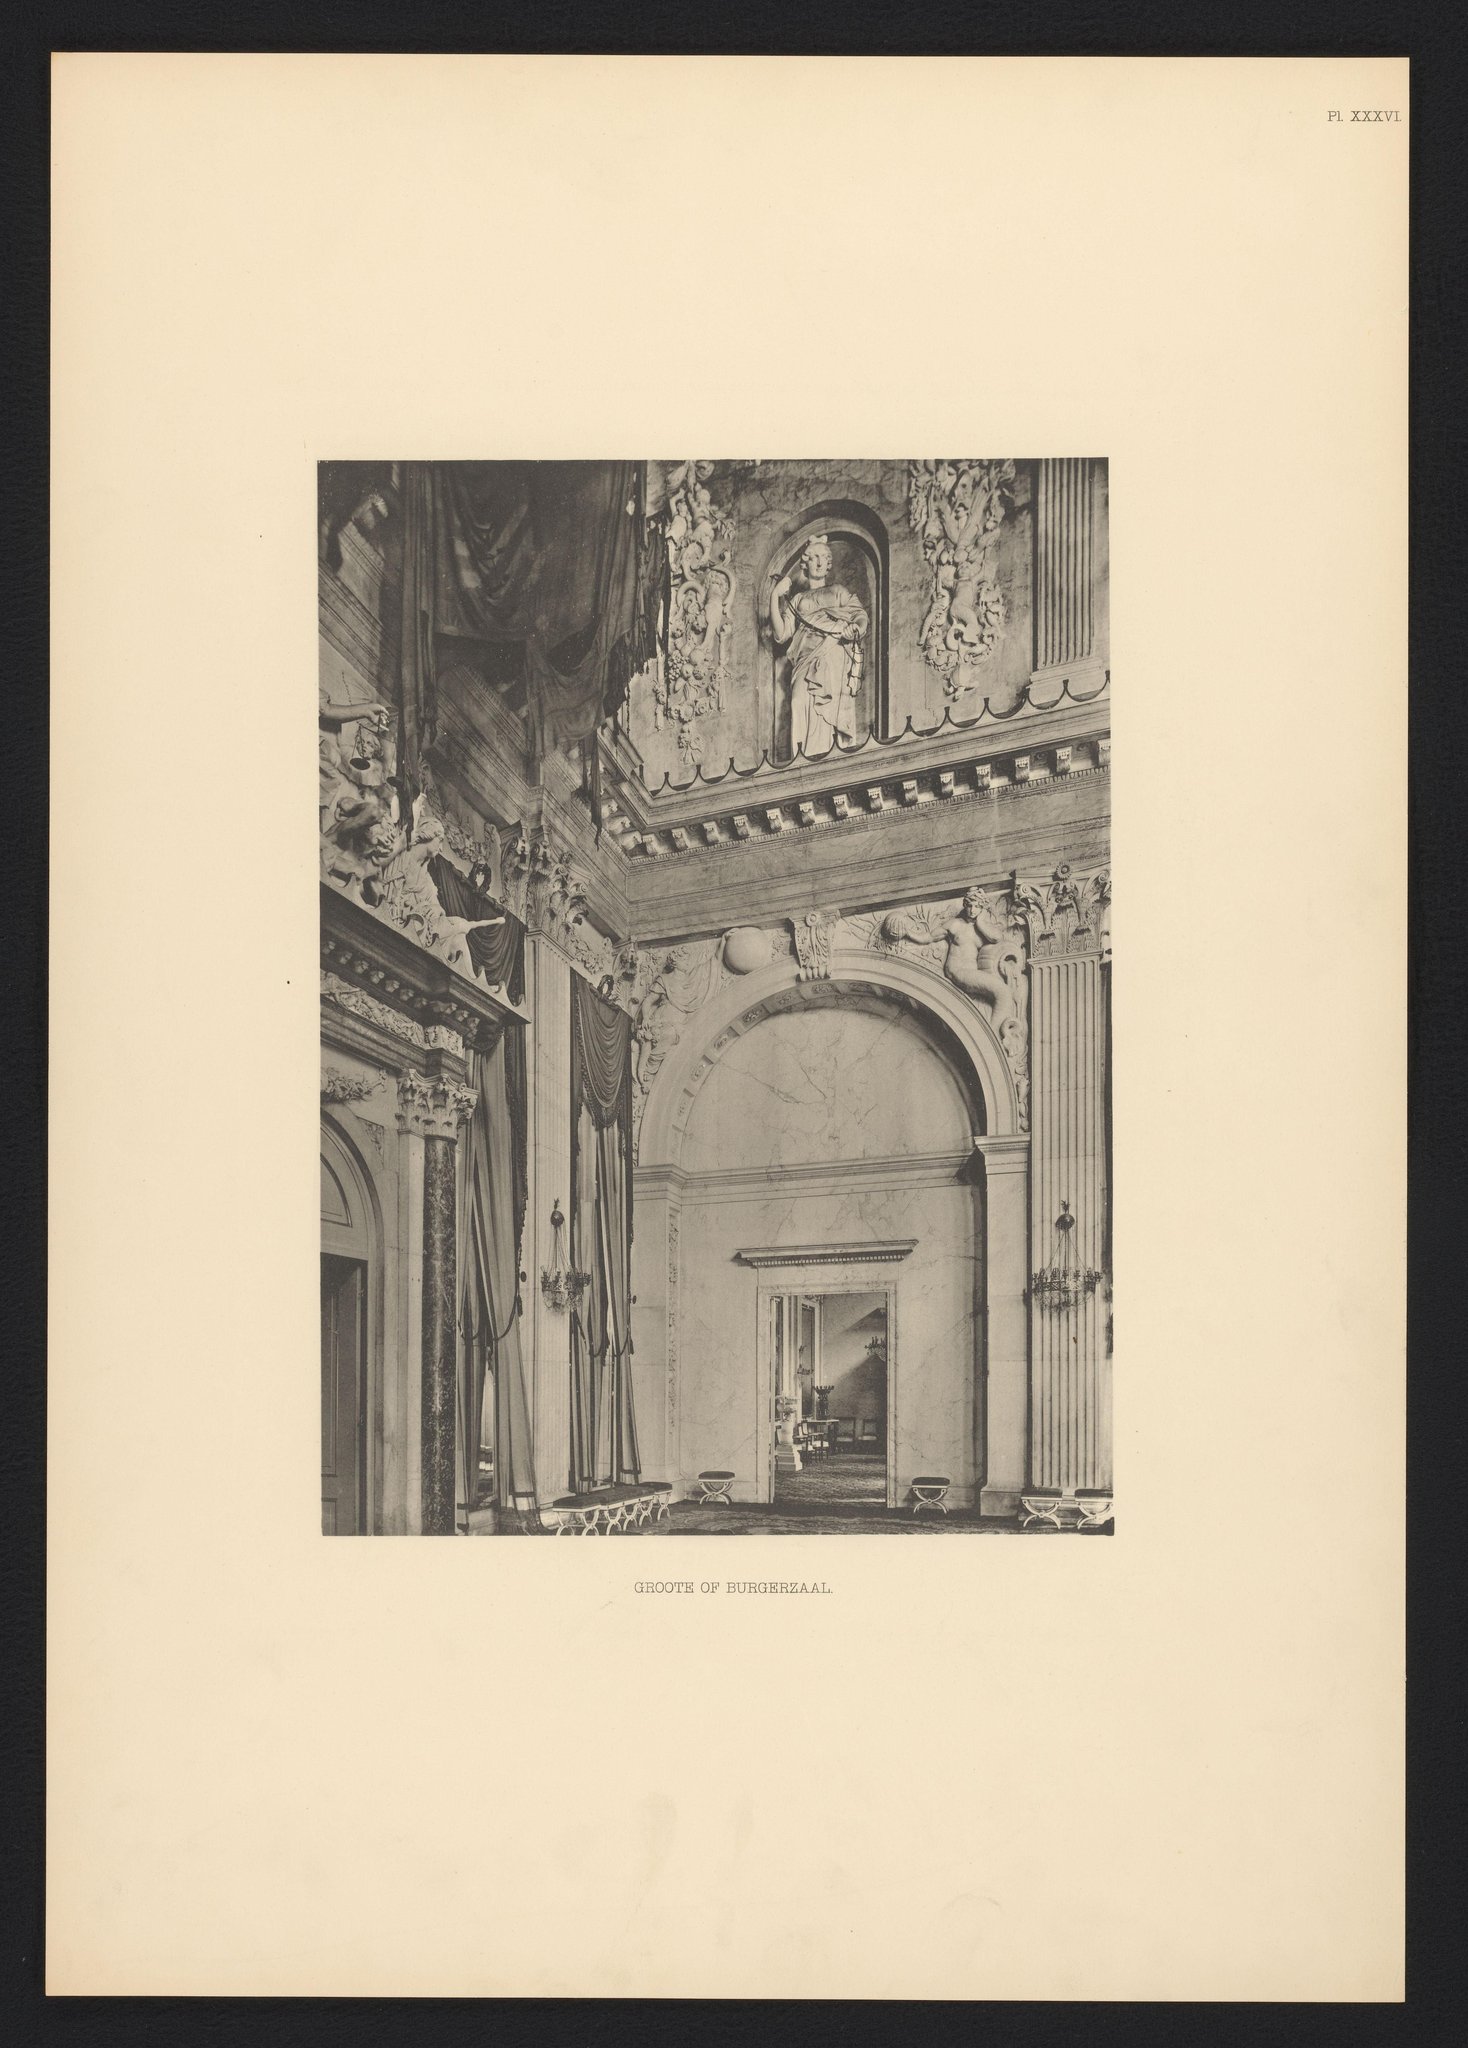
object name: photograph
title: Burgerzaal, Paleis op de Dam, Amsterdam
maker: Anonymous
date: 1899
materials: cardboard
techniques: photograph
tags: palace, interior of the house, royal palace of amsterdam